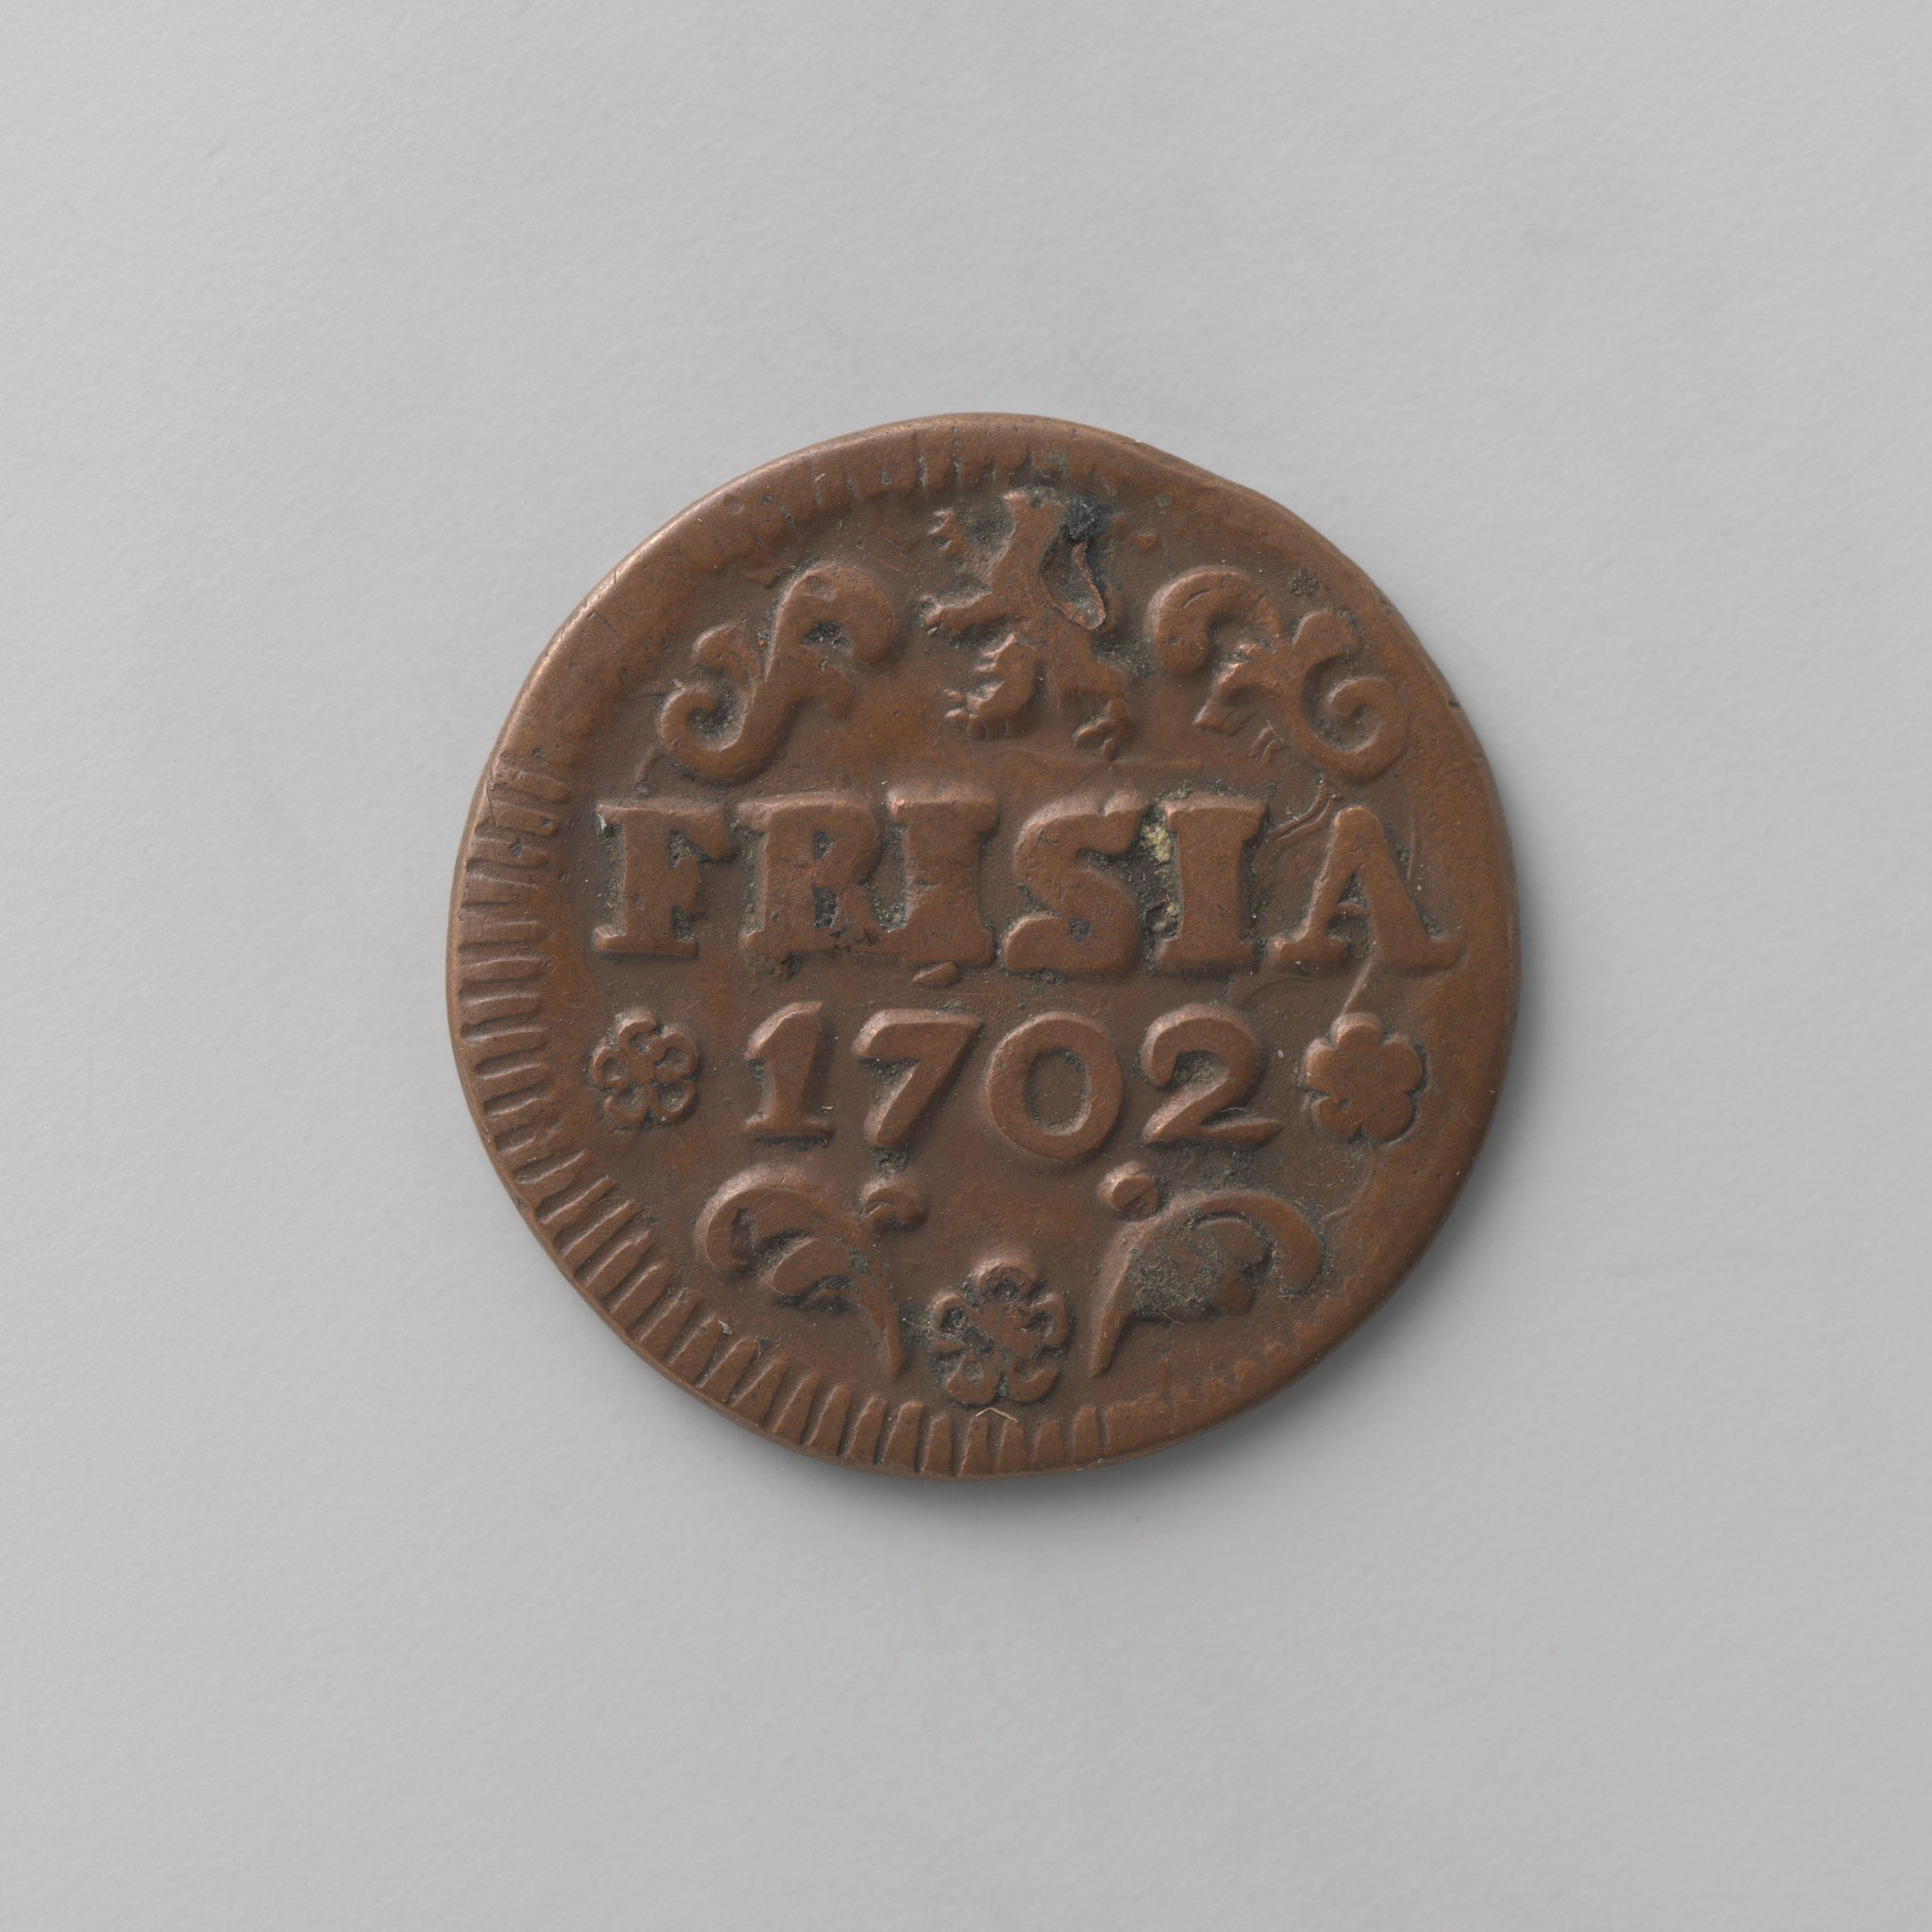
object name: coin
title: Duit van Friesland, 1702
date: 1702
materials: copper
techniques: striking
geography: leeuwarden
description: Koperen munt. Voorzijde: gekroond wapenschild van Friesland met naar boven uitwijkende bladversiering. Keerzijde: muntteken tussen guirlandes, daaronder opschrift in een regel, waaronder jaartal. Daaronder rozet tussen twee guirlandes.